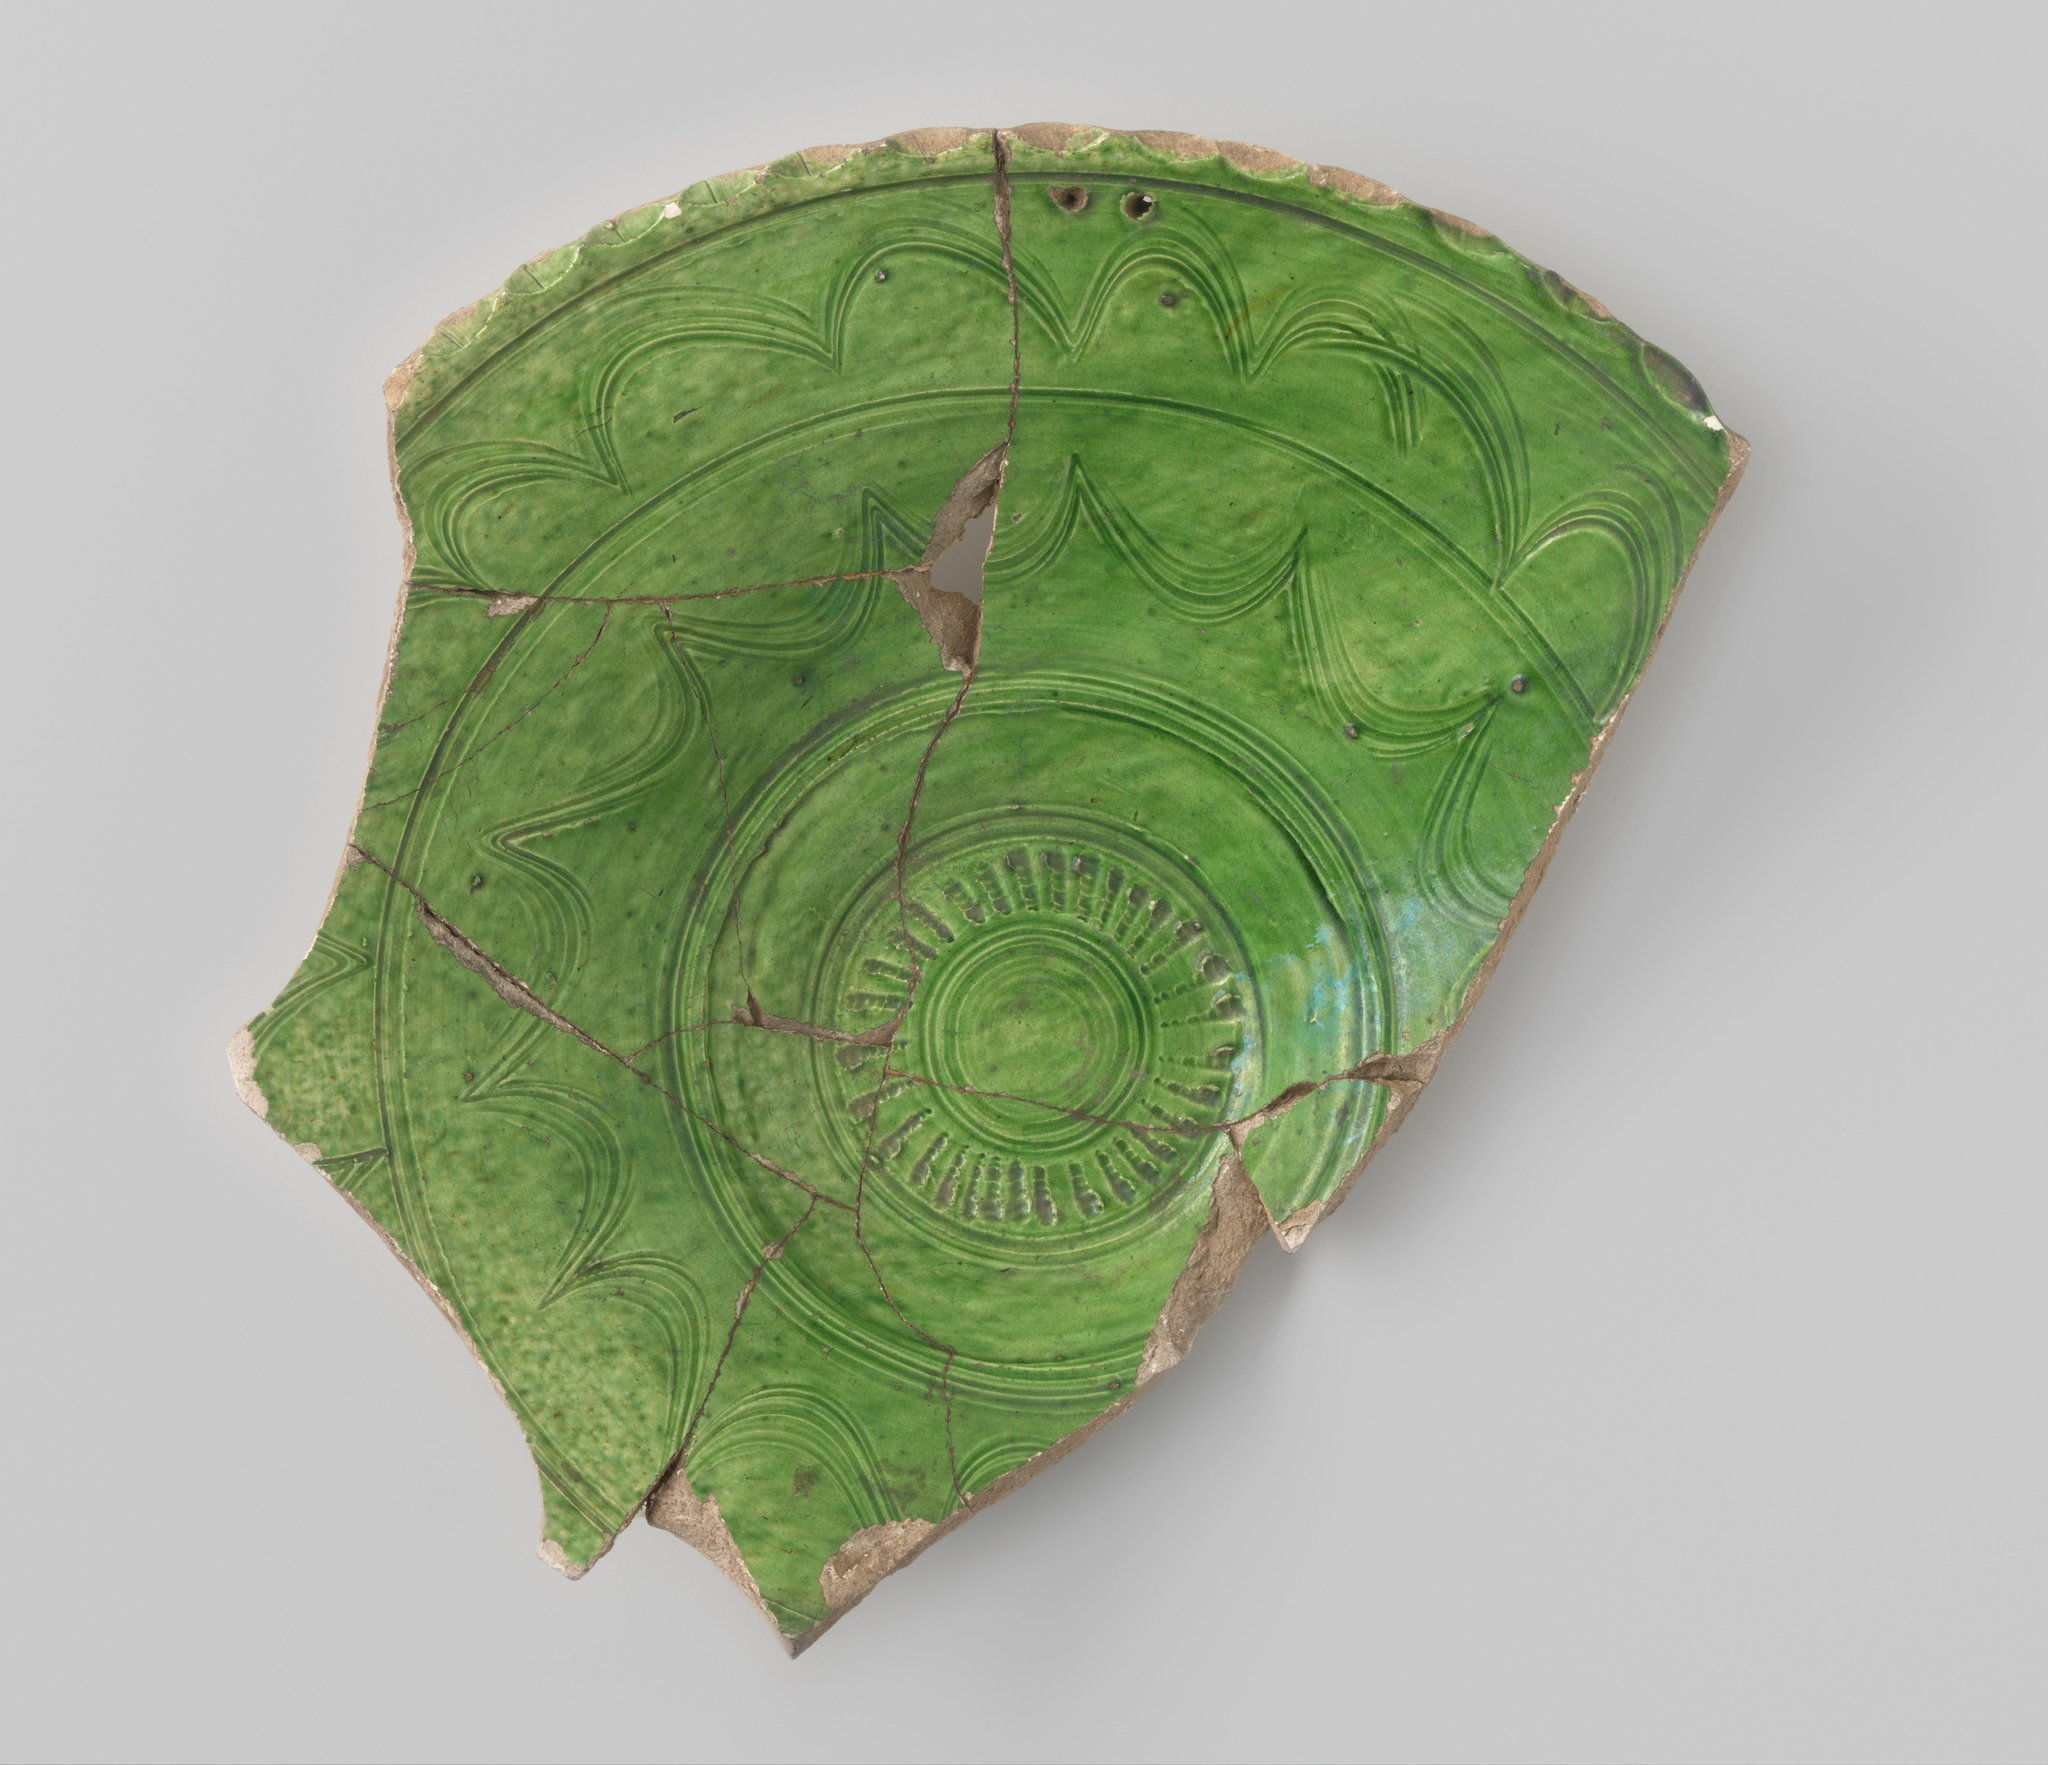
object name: platter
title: Fragment van verglaasde schotel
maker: Anonymous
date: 1500-1699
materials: earthenware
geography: northern netherlands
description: Fragment van een groen verglaasde schotel. Opmerking: opgegraven te Arnhem.